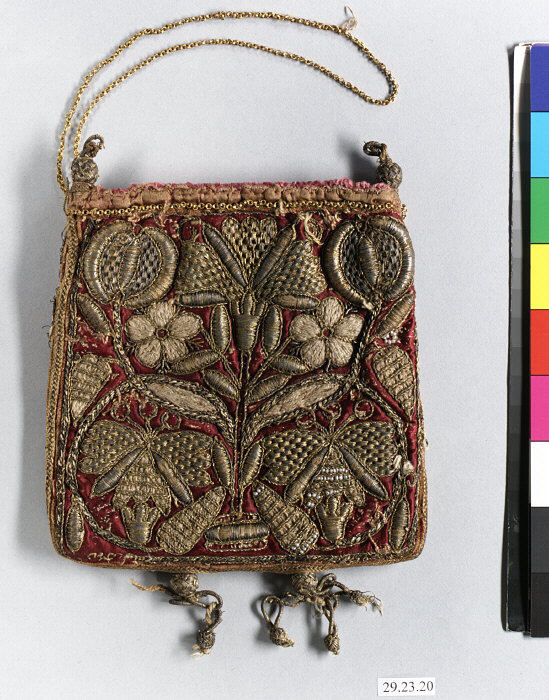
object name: bag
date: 1601-1633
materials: metal thread, silk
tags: flowers